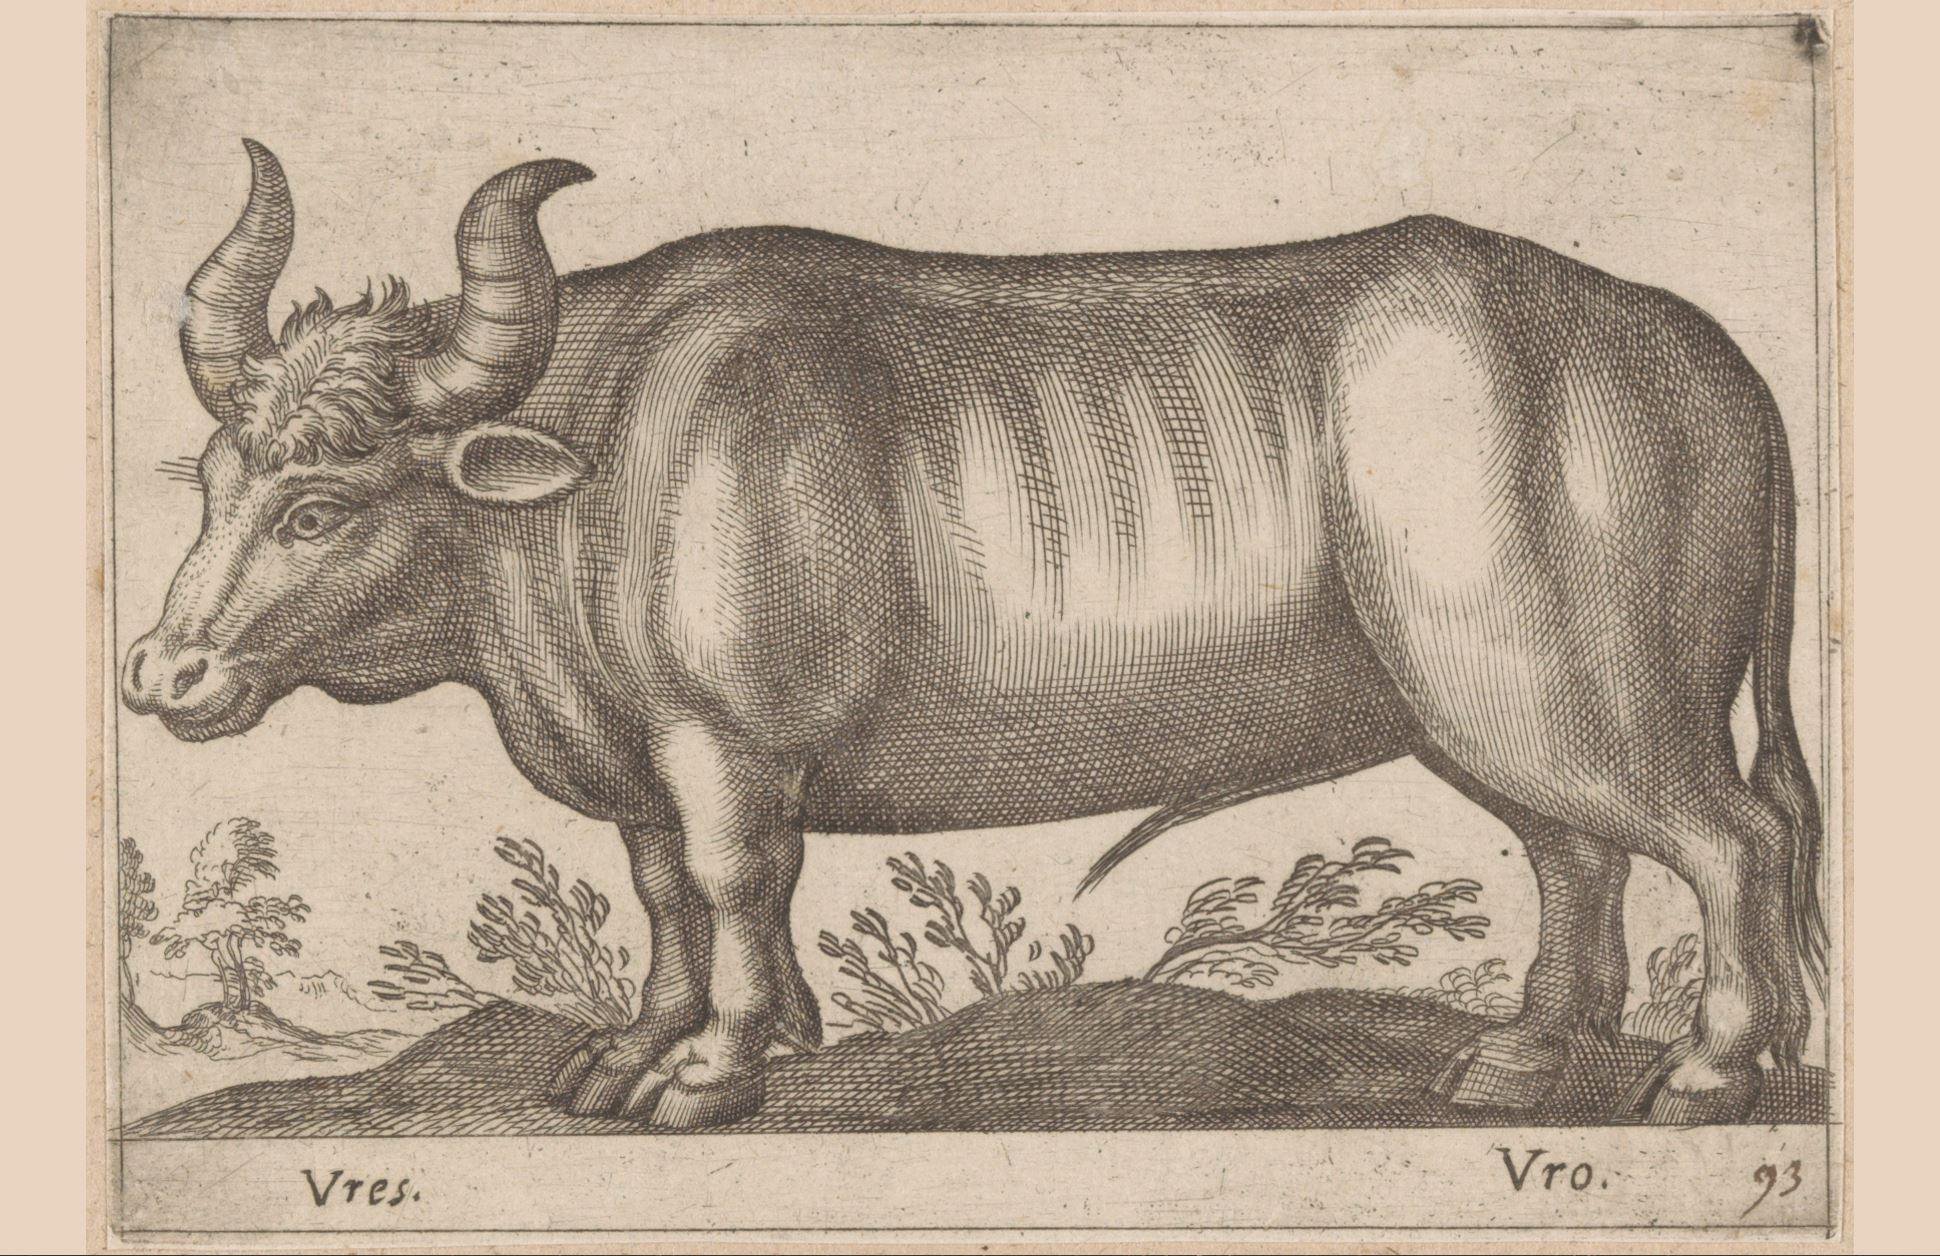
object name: print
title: Nova raccolta de li animali piu curiosi del mondo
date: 1565-1630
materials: paper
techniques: etching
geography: vatican city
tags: ox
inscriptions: collector's mark: Lugt 11, number: ‘93’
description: Deze prent maakt deel uit van een reeks prenten van dieren door Antonio Tempesta. Bekend is dat een tweede staat (met nummering) van deze serie is uitgegeven door Giovanni Giacomo de' Rossi in 1650. Onbekend is wie de eerste staat heeft uitgegeven en wanneer.